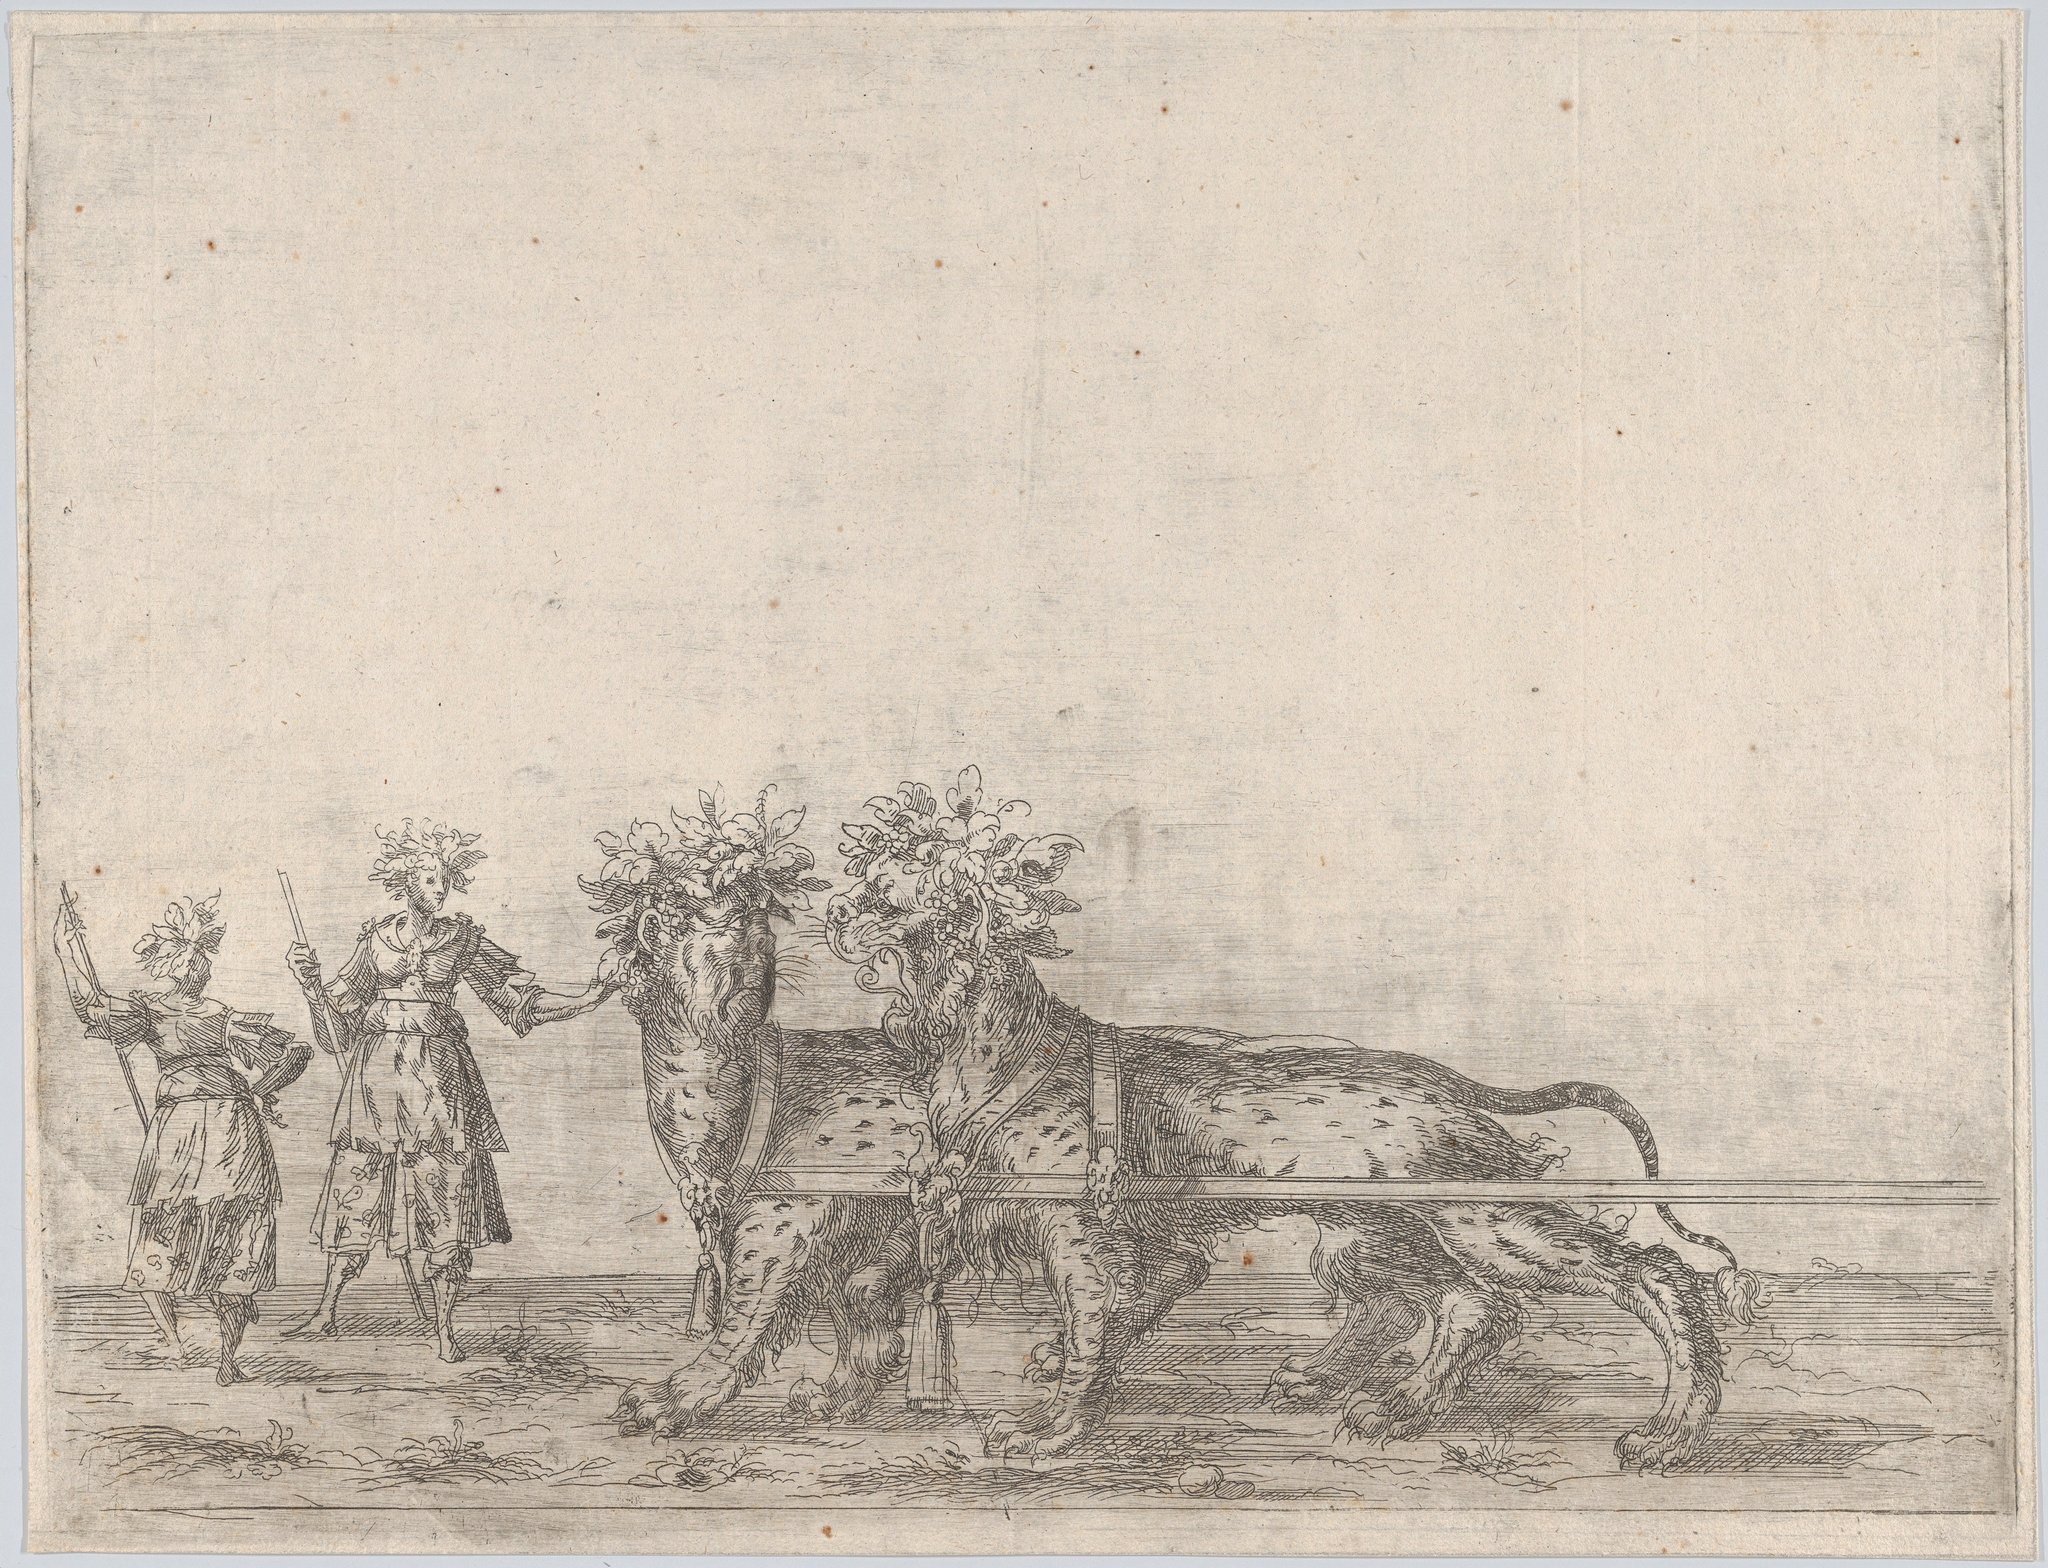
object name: print, fete, ornament architecture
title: Procession, with two figures and two lions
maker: anonymous, german, 16th century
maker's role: artist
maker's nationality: german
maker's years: 1500-1600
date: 1501-1600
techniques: etching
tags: men,lions